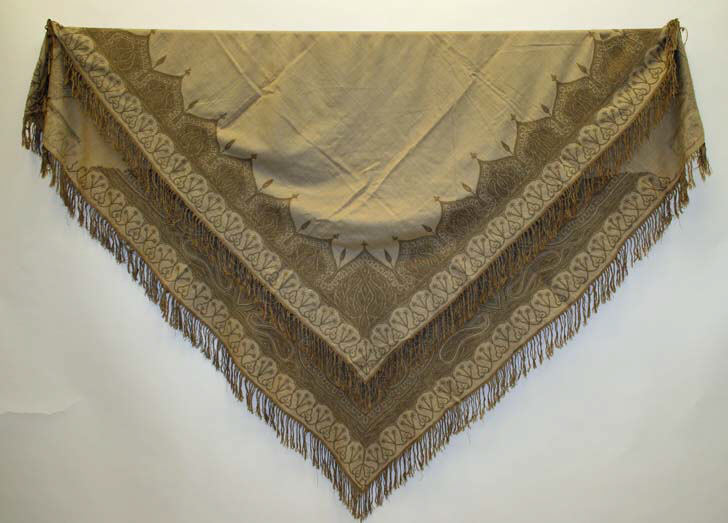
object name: shawl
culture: middle eastern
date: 1834-1866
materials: silk, wool